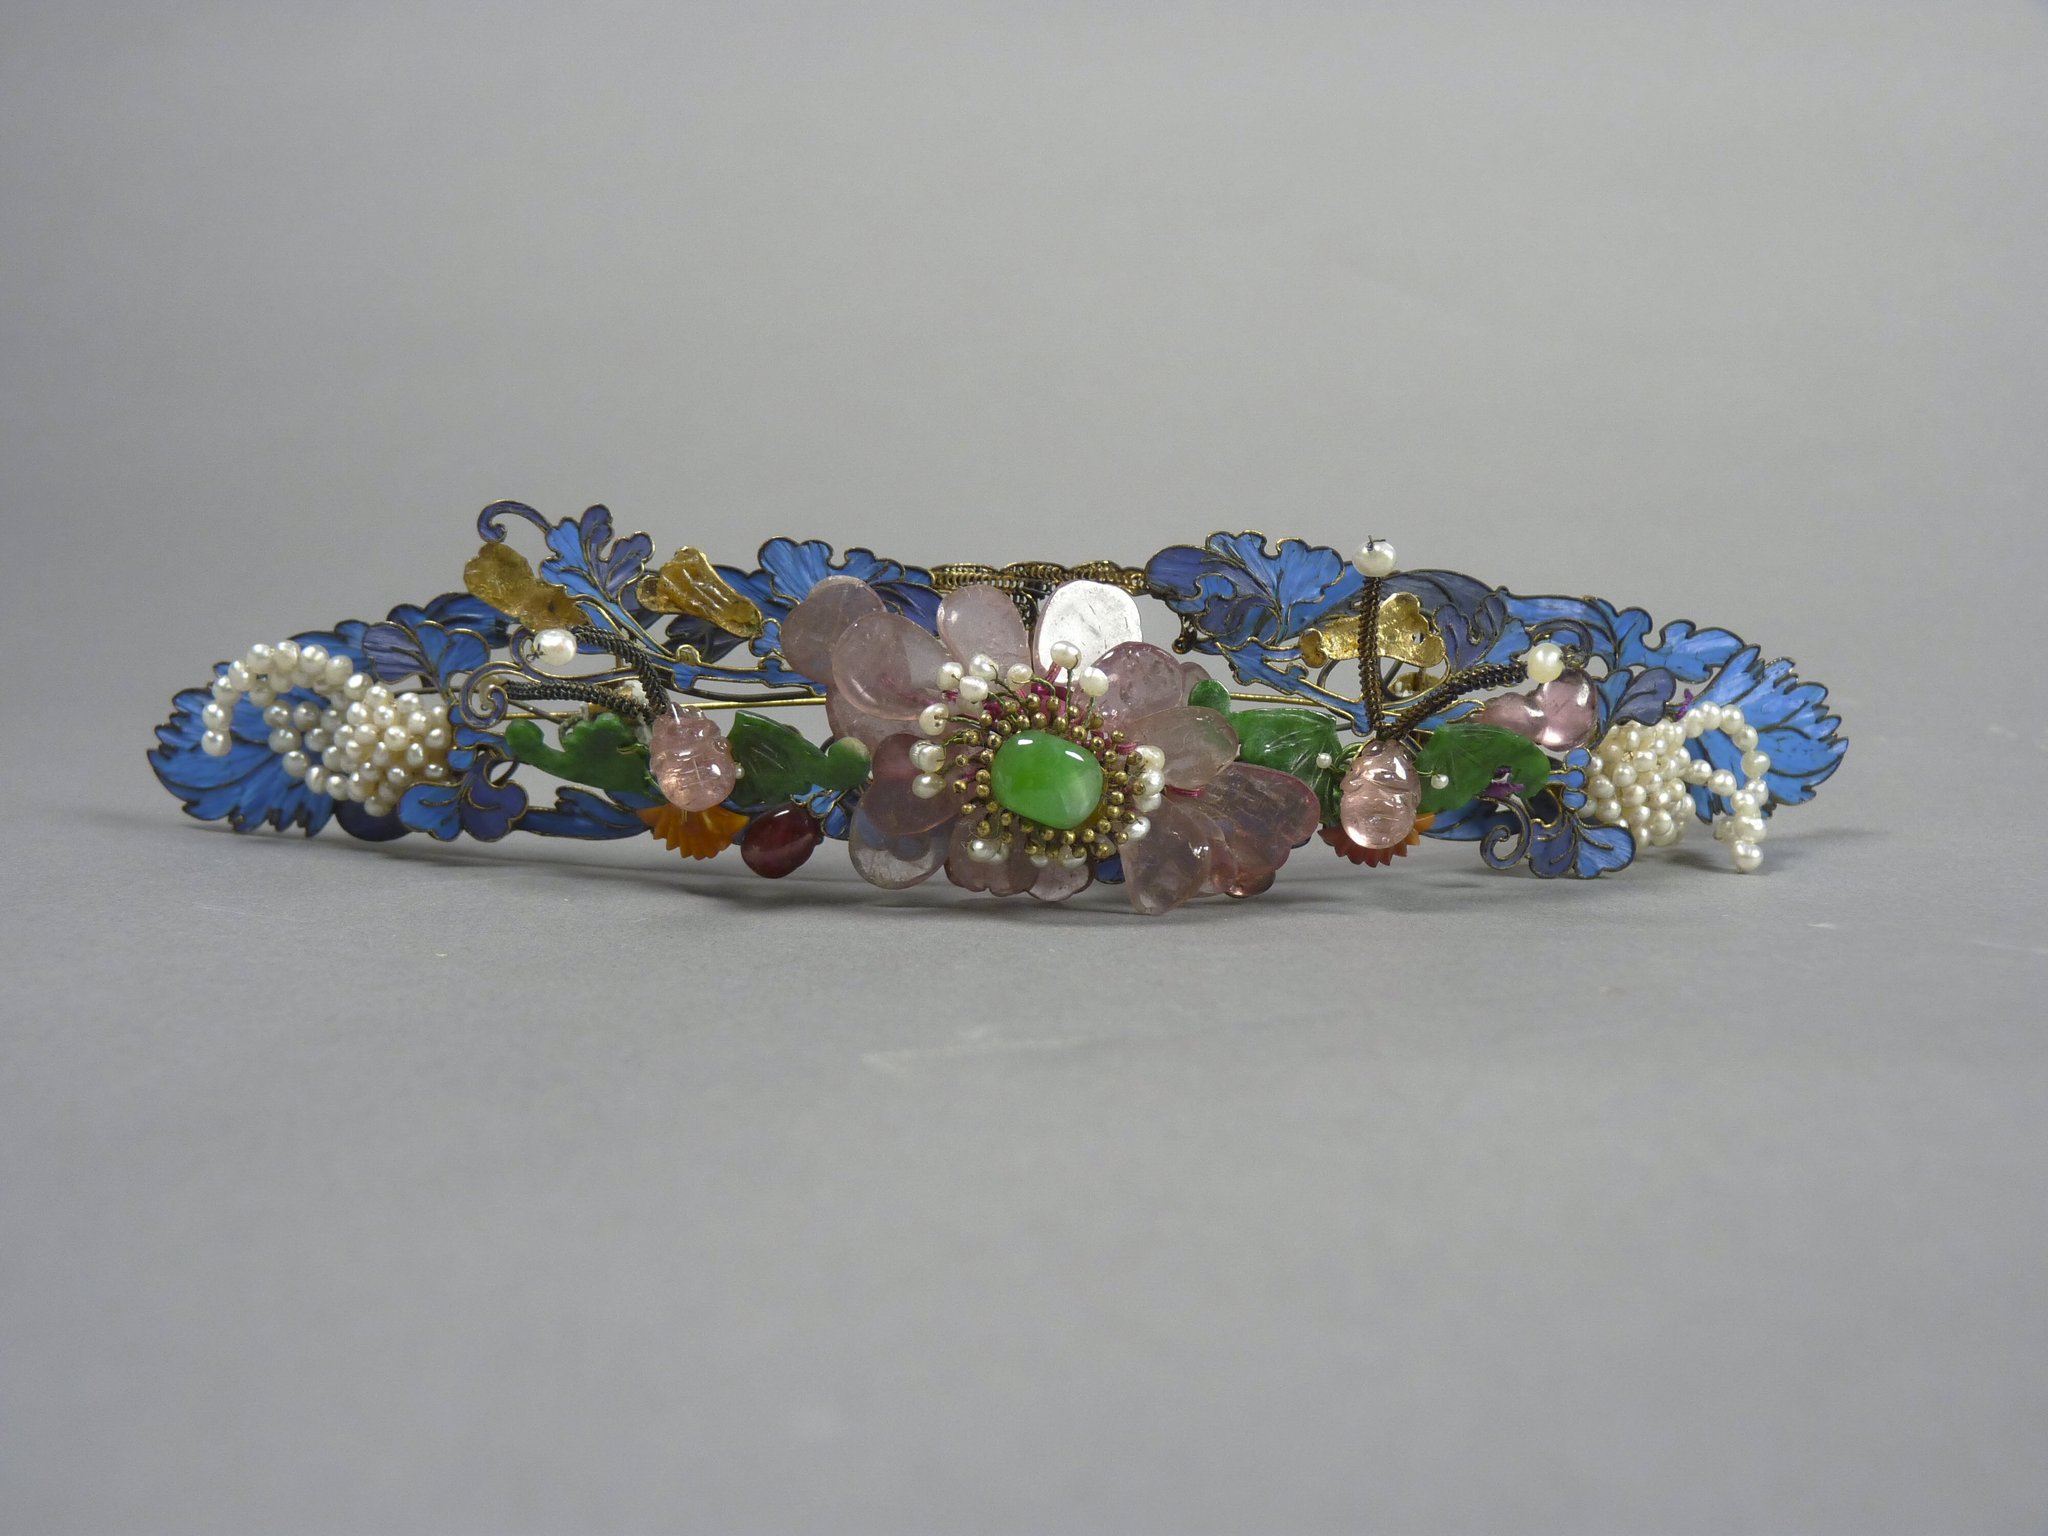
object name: hat ornament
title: Ornaments for a Woman's Hat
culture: chinese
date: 1701-1900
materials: feather, glass, gold, metal, stone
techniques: gilding